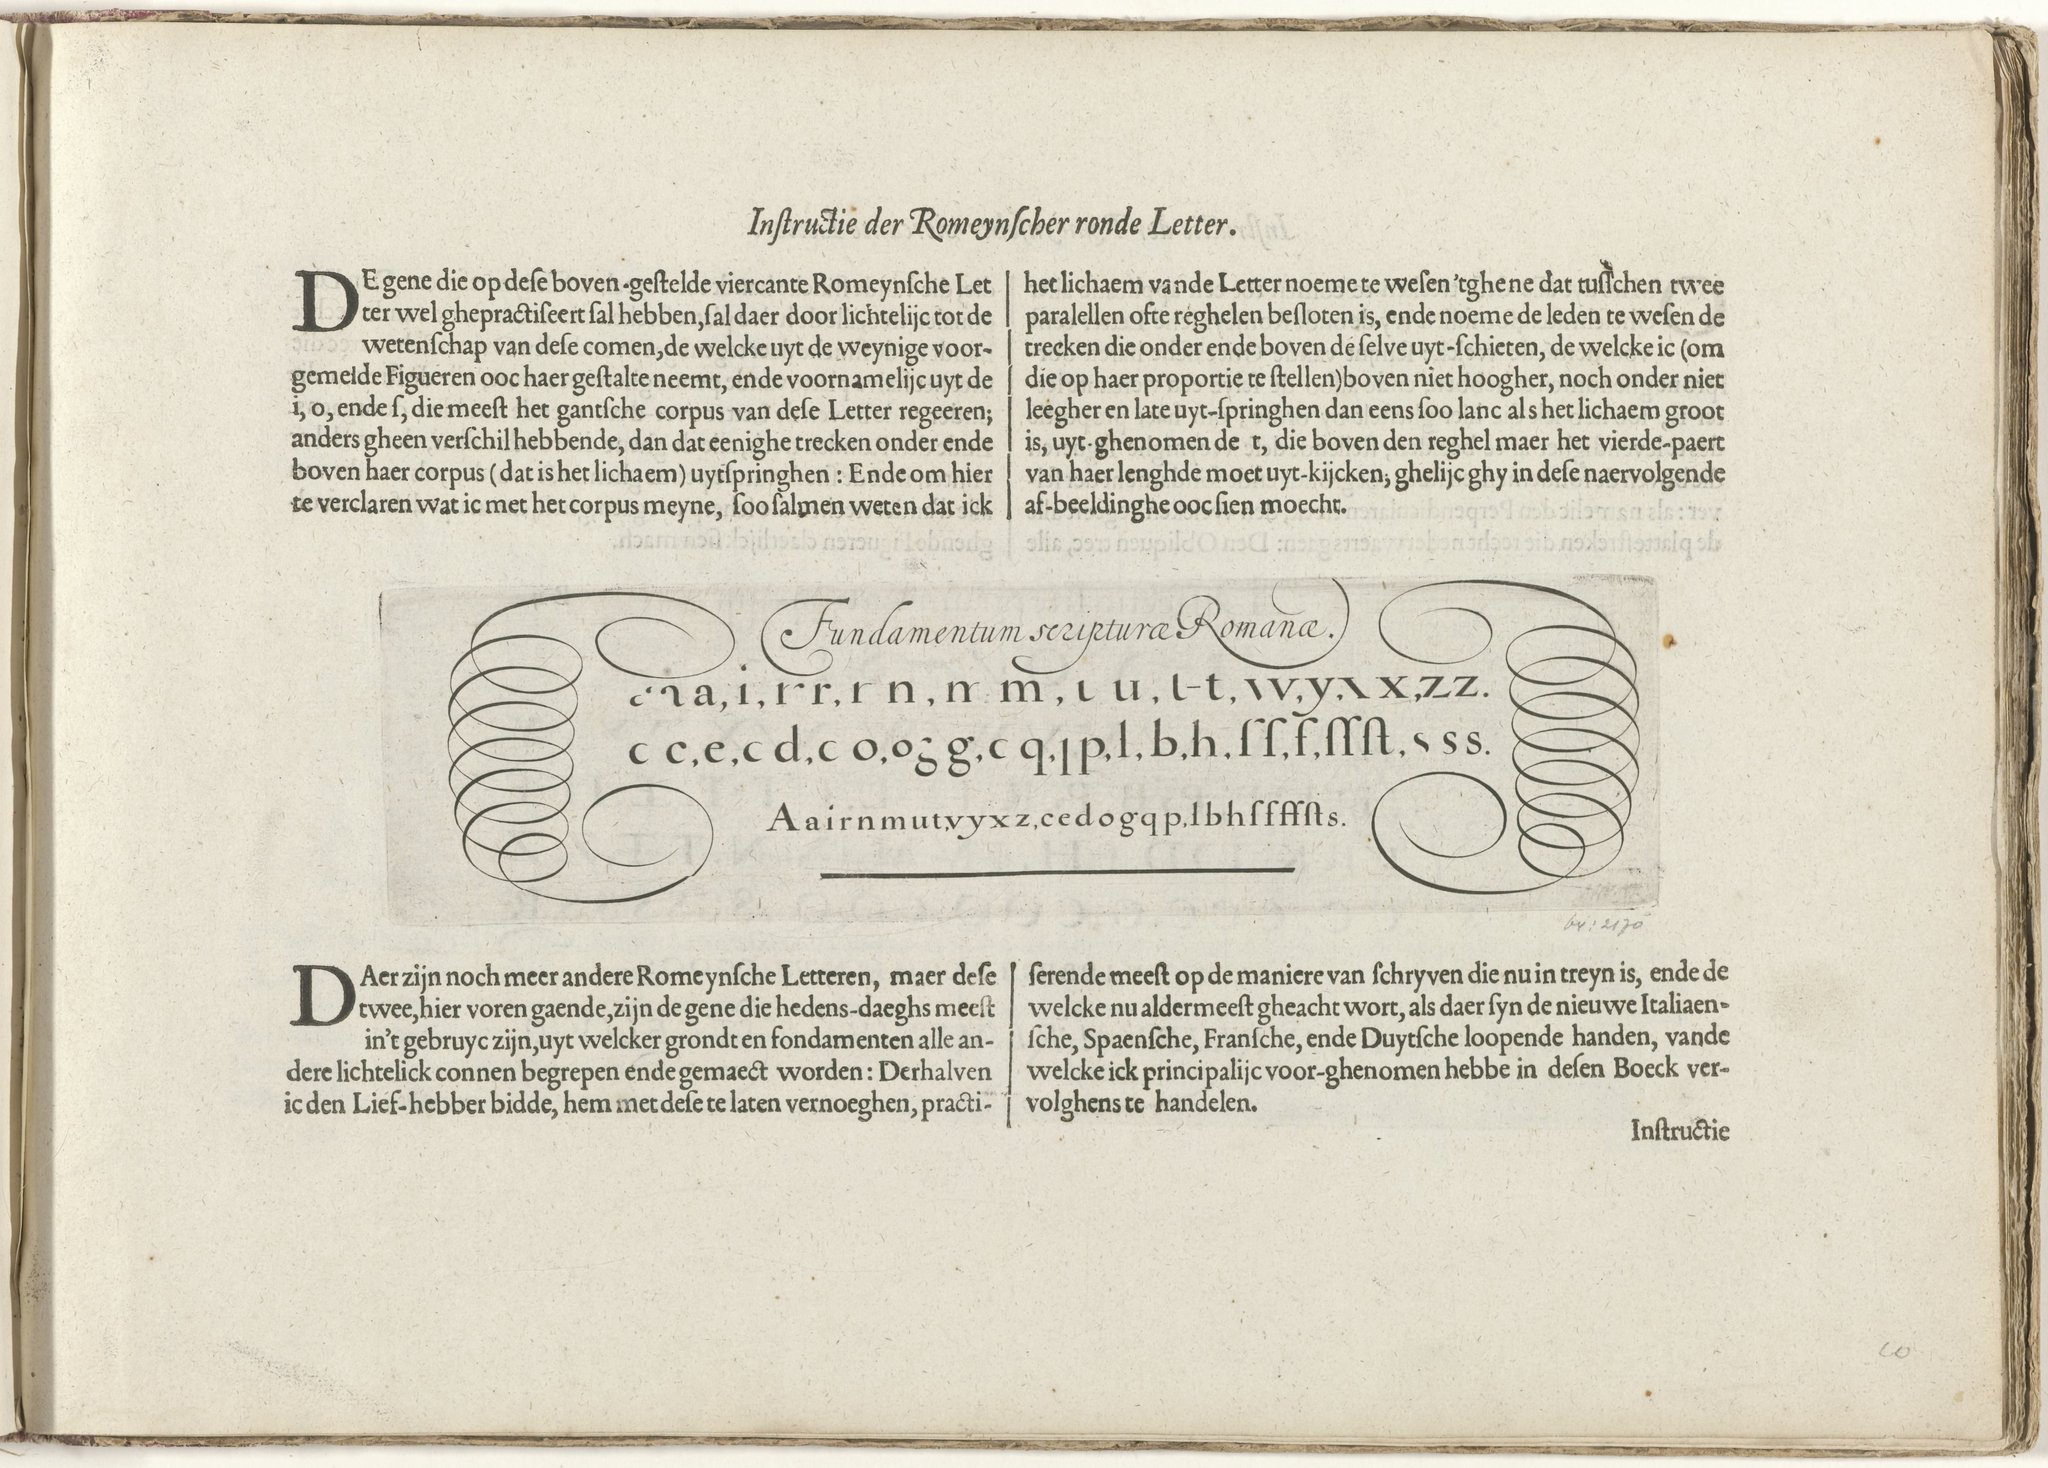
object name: print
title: Spieghel der schrijfkonste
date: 1605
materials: paper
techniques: engraving, letterpress printing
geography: amsterdam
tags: calligraphy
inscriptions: collector's mark: Lugt 2228, collector's mark: Lugt 2760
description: Folio B2v met een schrijfvoorbeeld getiteld: Fundamentum scripturae Romanae. Het blad maakt deel uit van een album.